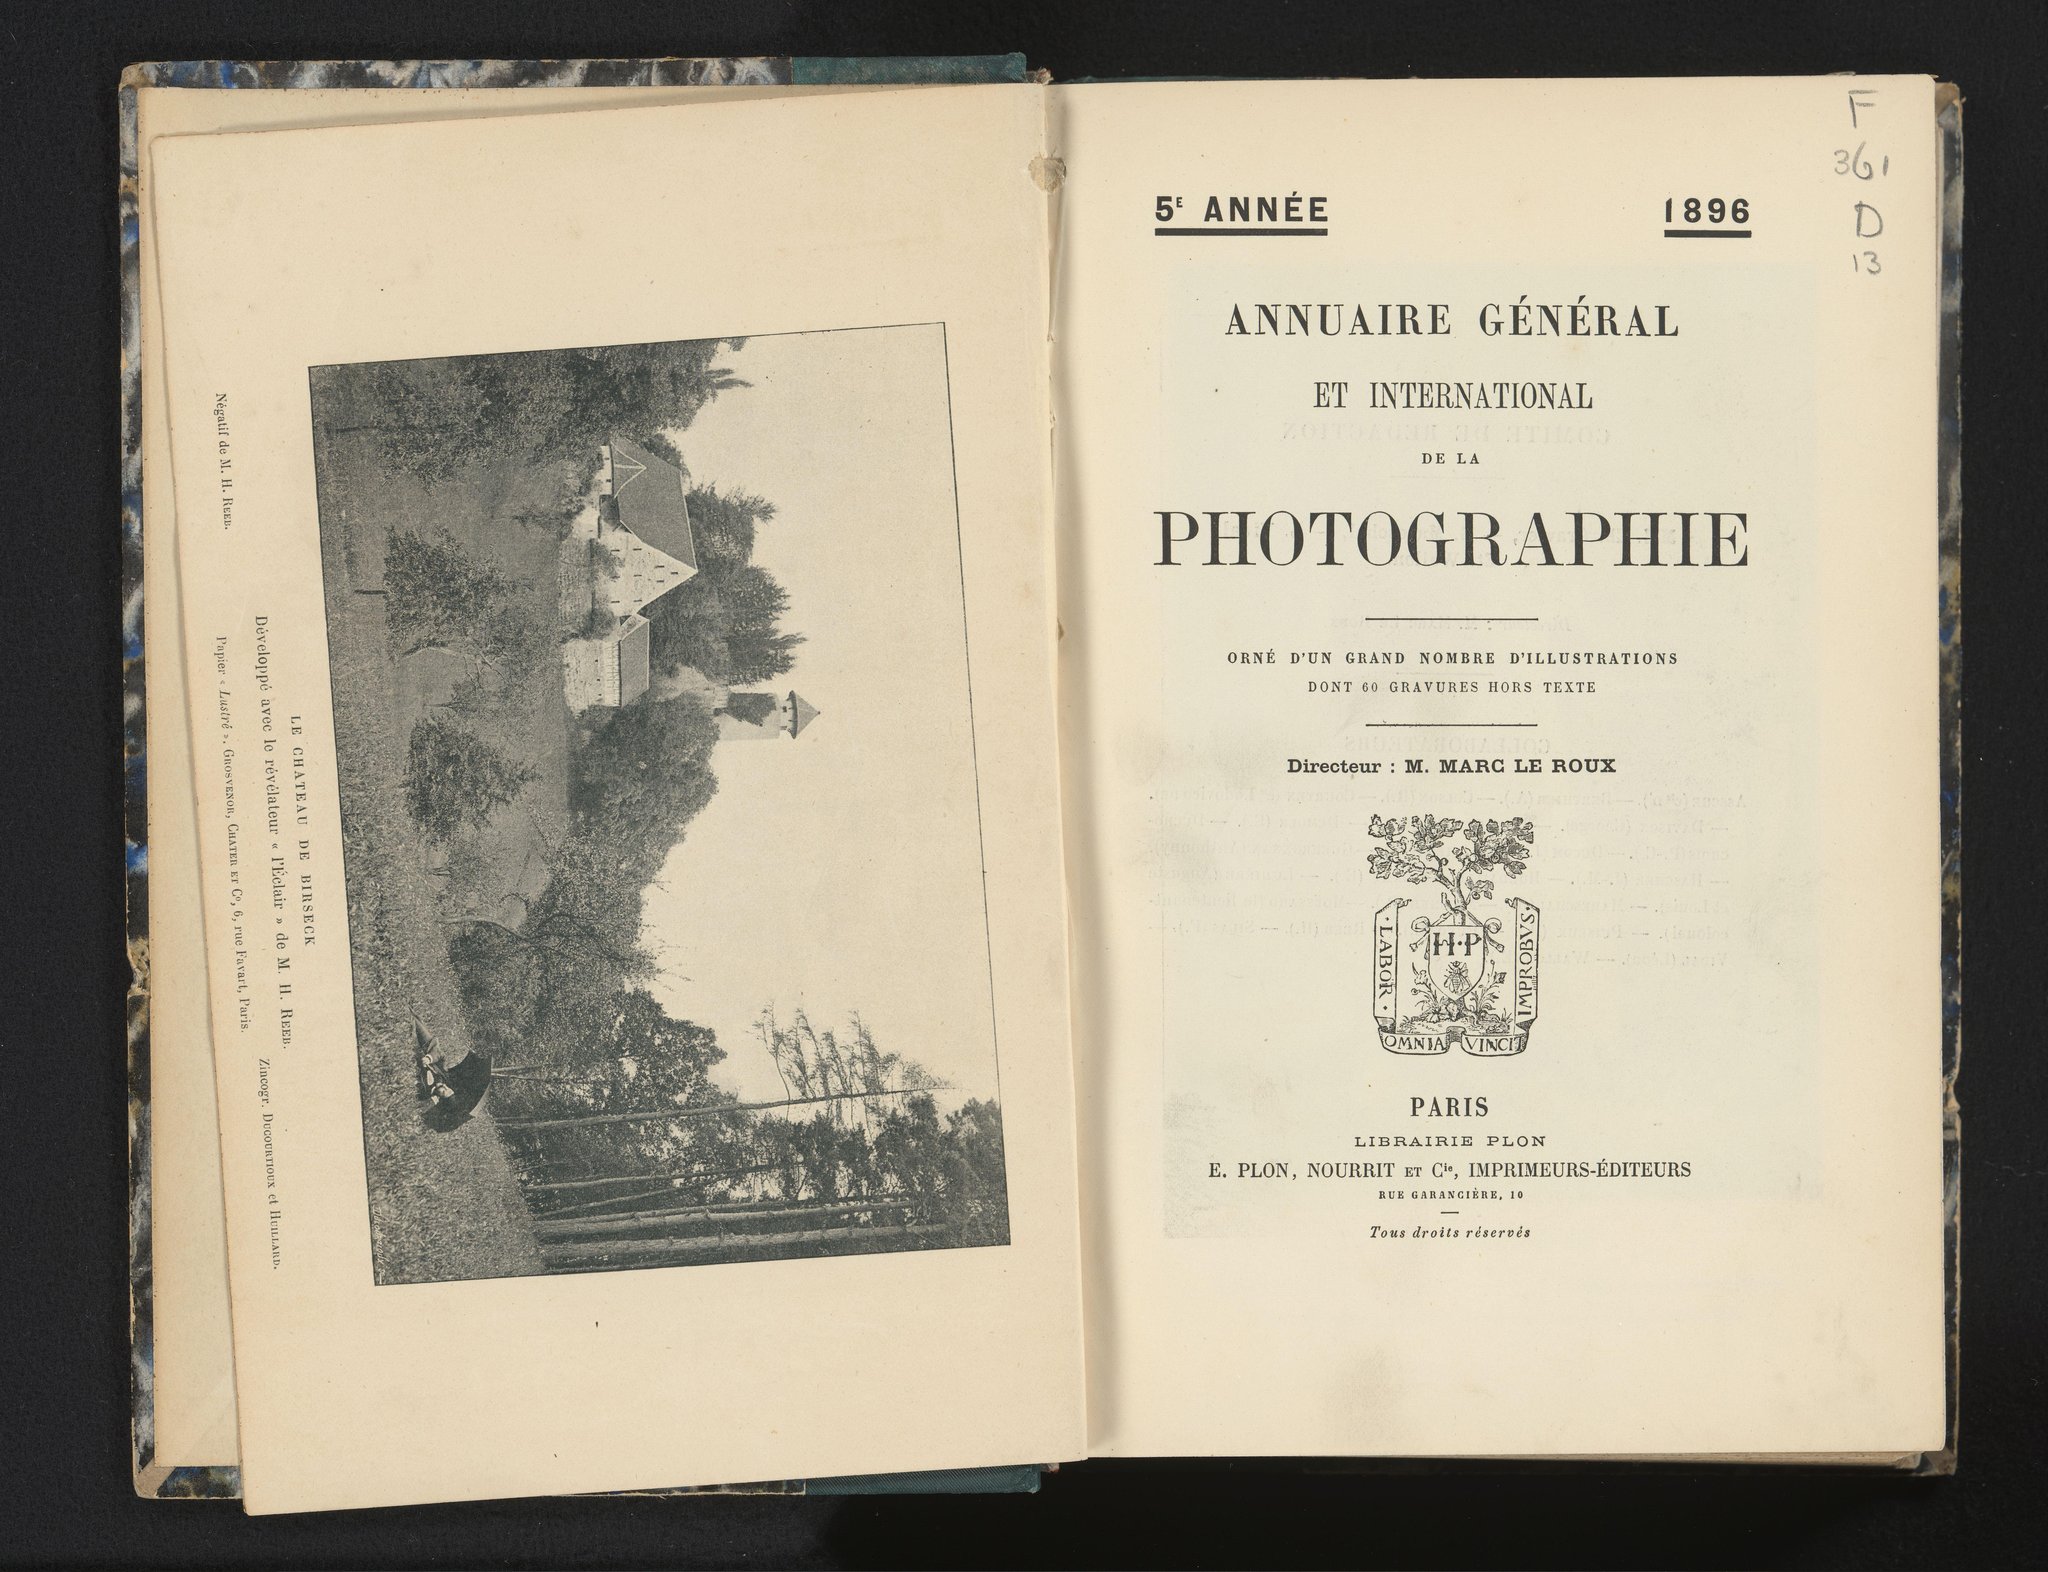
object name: book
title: Annuaire général et international de la photographie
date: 1896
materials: cardboard, linen, paper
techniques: photograph, decorated paper, photoaquatint, printing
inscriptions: number: ‘1.000,-’, date: ‘JUNE/ 1990’, number: ‘7745 13/ 22’